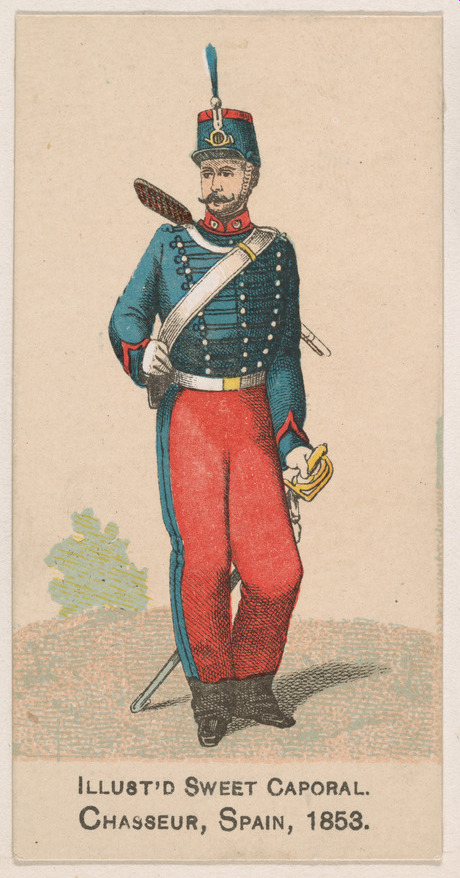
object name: print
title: Chasseur, Spain, 1853, from the Military Series (N224) issued by Kinney Tobacco Company to promote Sweet Caporal Cigarettes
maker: kinney brothers tobacco company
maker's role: publisher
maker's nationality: american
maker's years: 1869-2011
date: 1888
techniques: color lithograph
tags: military,men